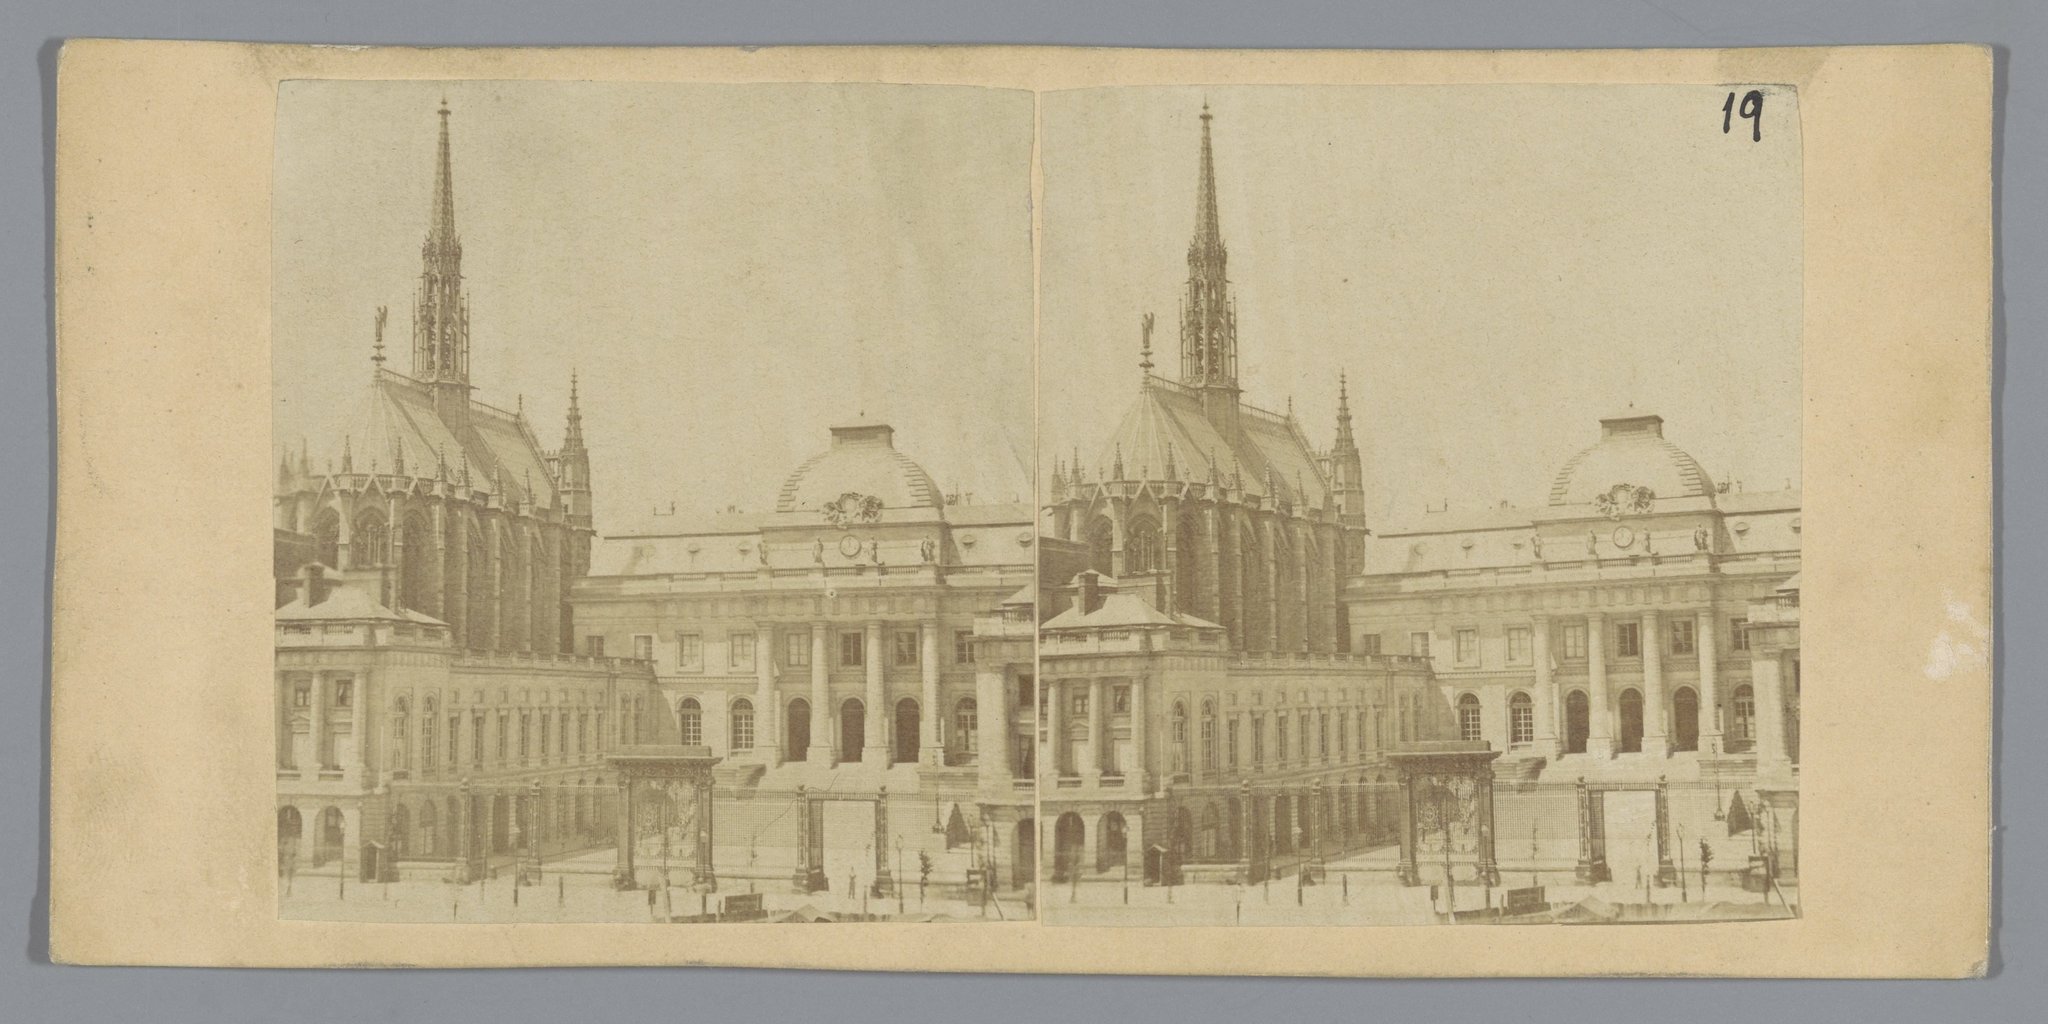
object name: stereograph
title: Sainte-Chapelle en het Paleis van Justitie, Parijs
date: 1851-1880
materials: cardboard, paper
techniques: albumen print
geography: paris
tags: court building, church (exterior), paris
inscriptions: number: ‘19’, retailer's mark: ‘222, rue de Rivoli/ en face le Jardin des Tuileries./ Lecocq-Frêne/ Estampes Photographies/ Plans et Guides pour Voyageurs/ Vues pr Stéreoscopes.’